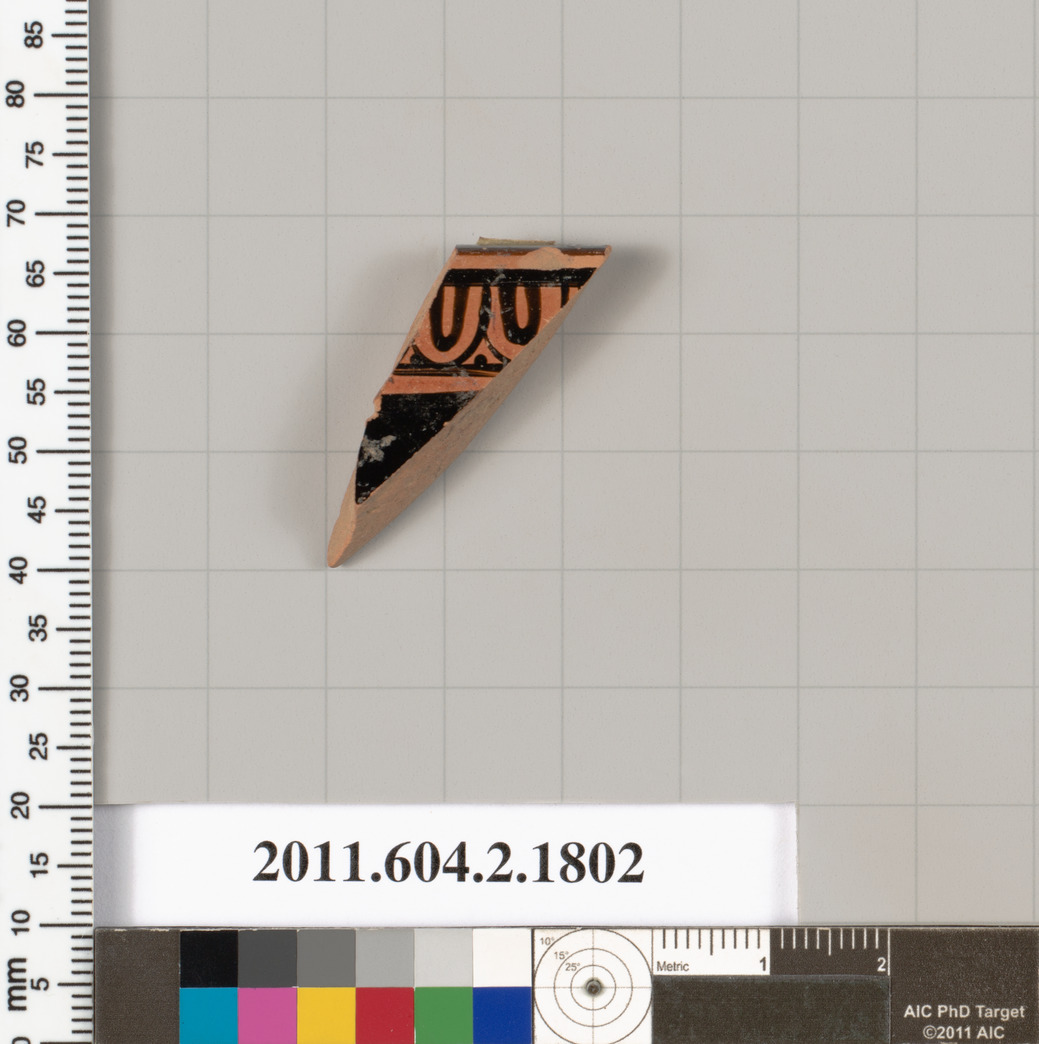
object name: skyphos fragment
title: Terracotta rim fragment of a skyphos (deep drinking cup)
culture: greek, attic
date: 460-440 BCE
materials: terracotta